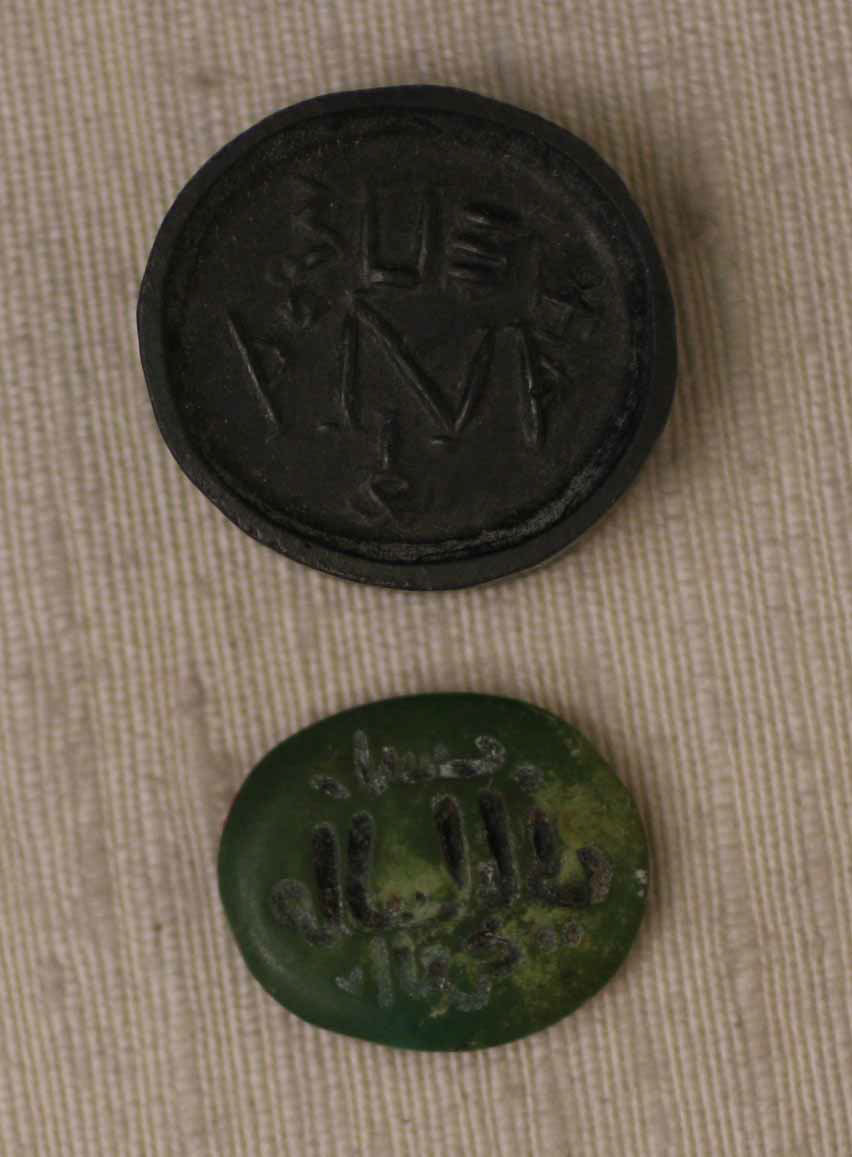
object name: seal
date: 1001-1100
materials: ivory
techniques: stain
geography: egypt